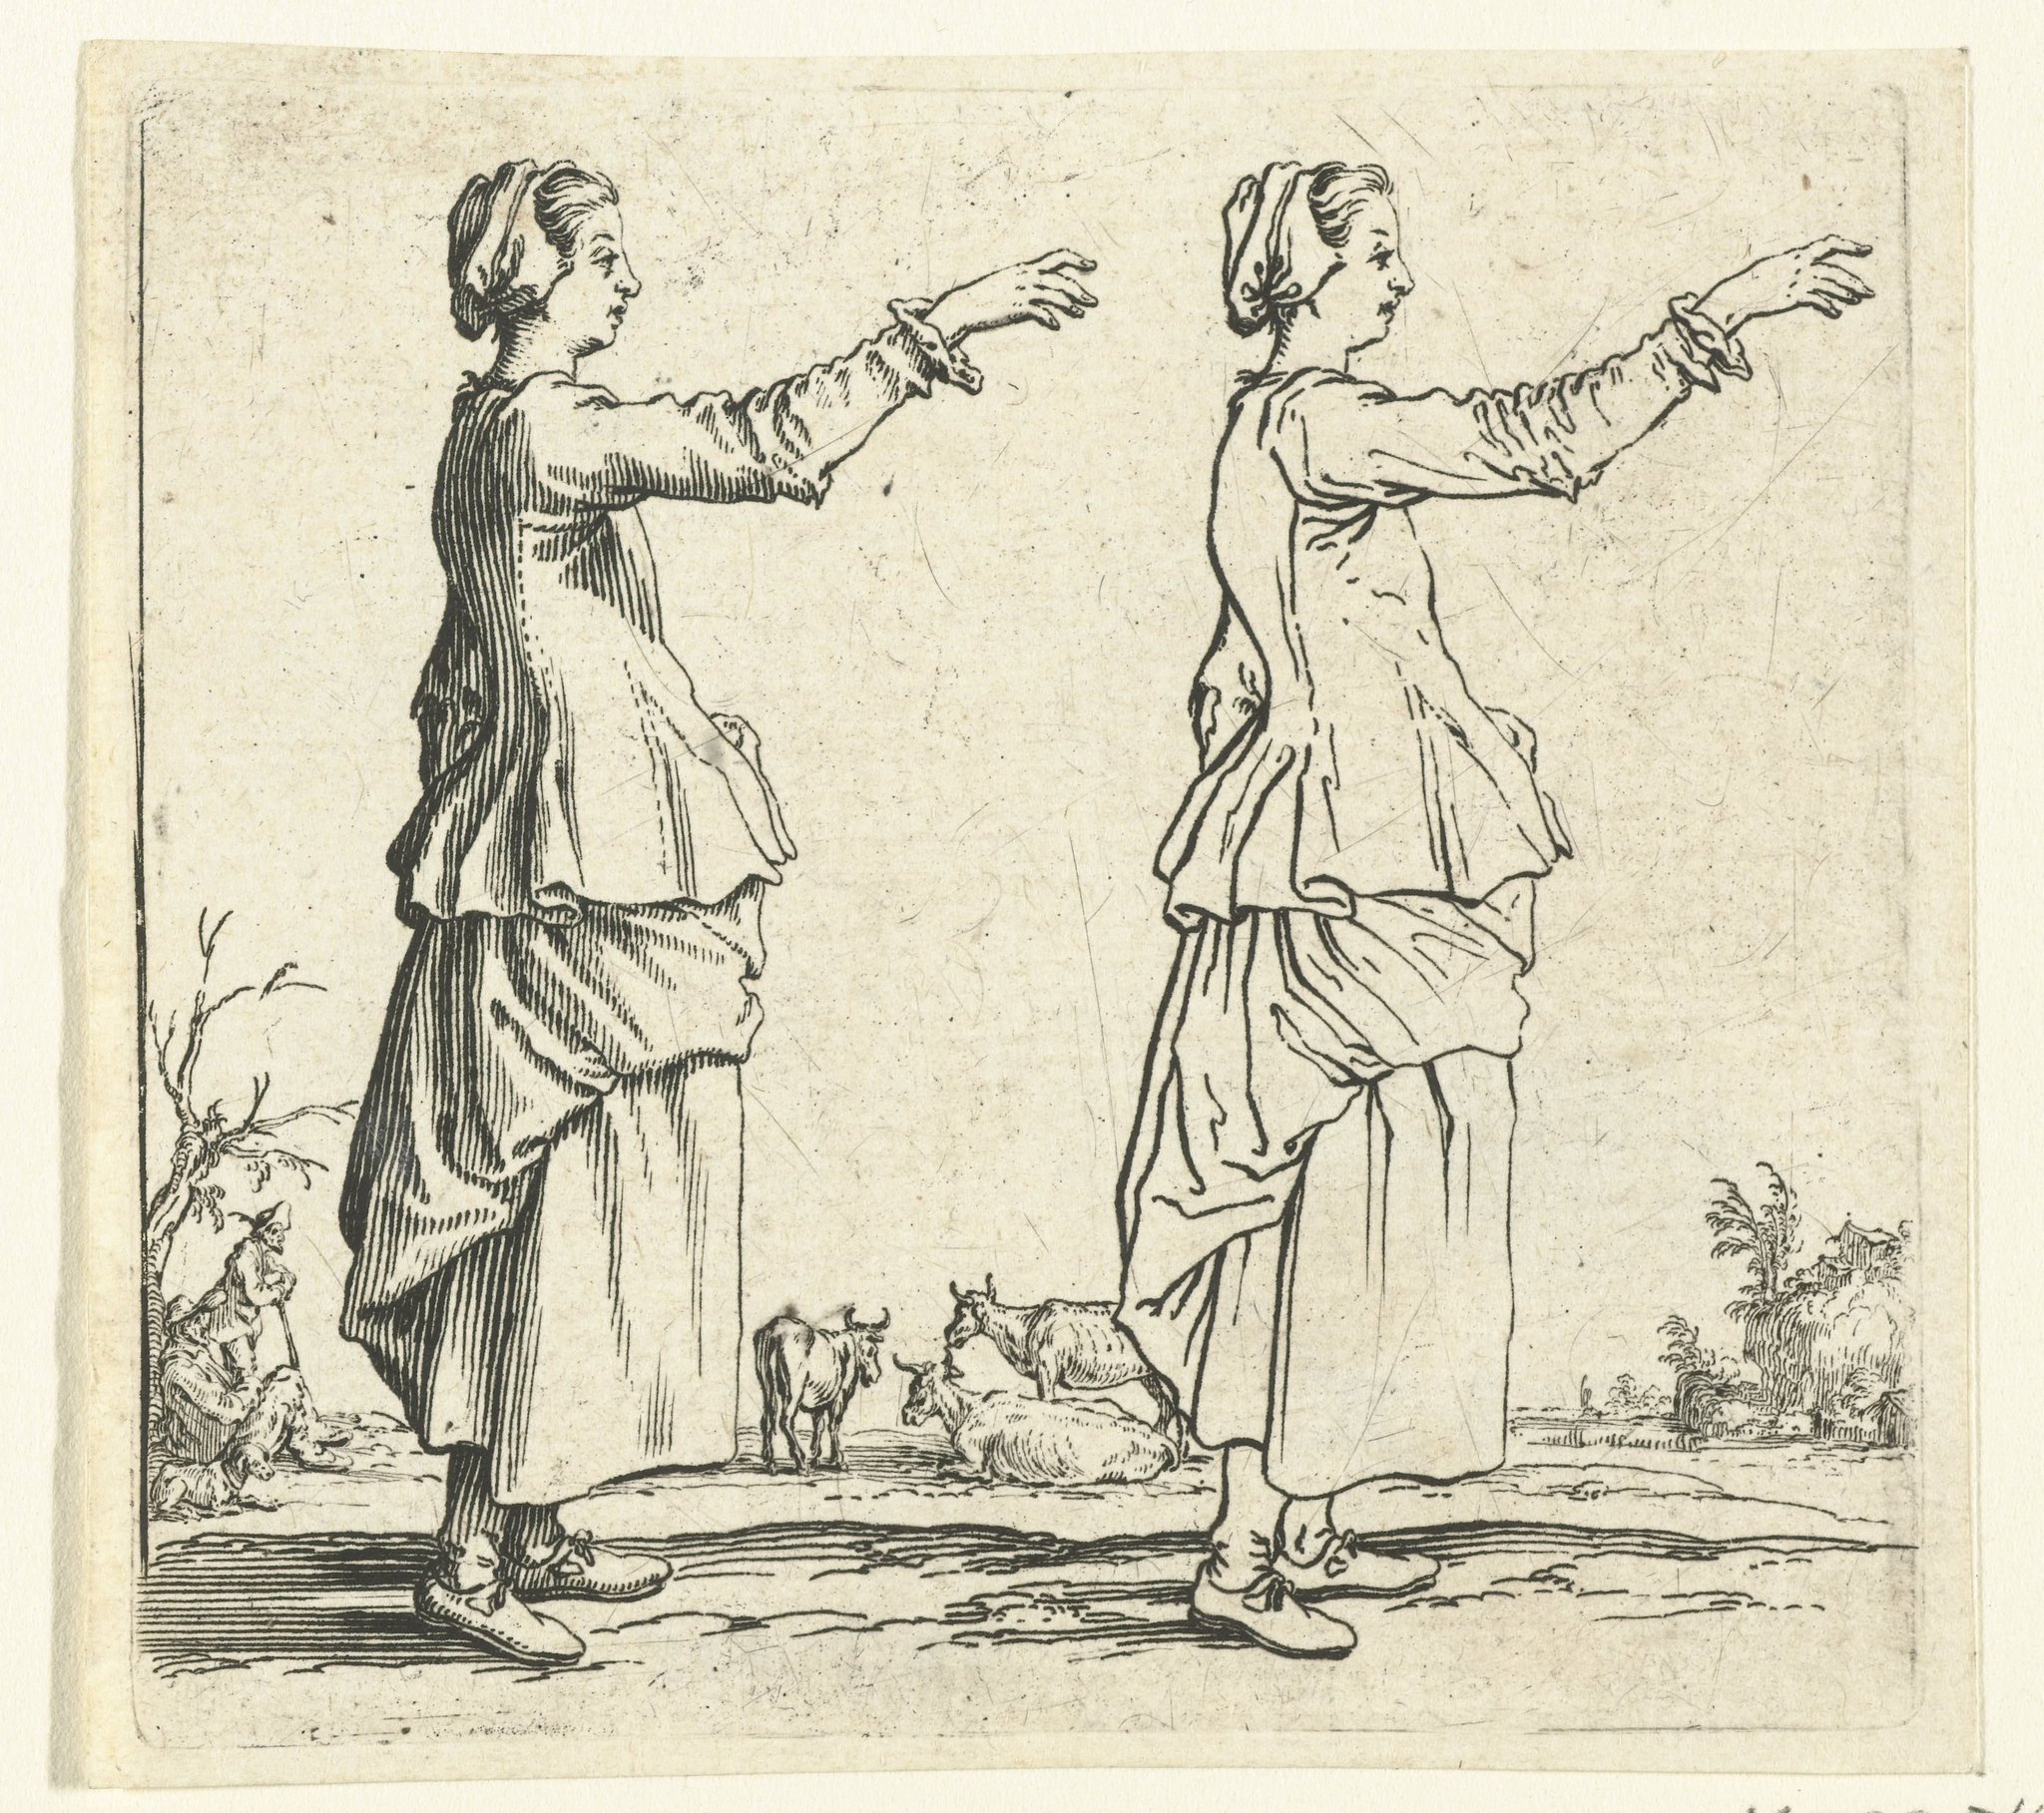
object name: print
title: Tweemaal dezelfde boerin met opgeheven arm, op de rechterzijde gezien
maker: jacques callot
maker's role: draughtsman, print maker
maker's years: 1592-1635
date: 1621-1624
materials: paper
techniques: etching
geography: nancy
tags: farmers - aa - female farmer, farmer's wife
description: Een boerin, de rechterarm in een wijzend gebaar opgeheven, op de rechterzijde gezien, tweemaal afgebeeld: rechts als lijnfiguur, links meer uitgewerkt met schaduwpartijen. Op de achtergrond twee figuurtjes en drie koeien. Deze prent is onderdeel van een serie van 16 prenten (15 volgens Lieure; 17 resp. 16 incl. titelprent) met mannen en vrouwen in diverse houdingen. Mogelijk zijn deze prenten bedoeld geweest als tekenvoorbeelden.